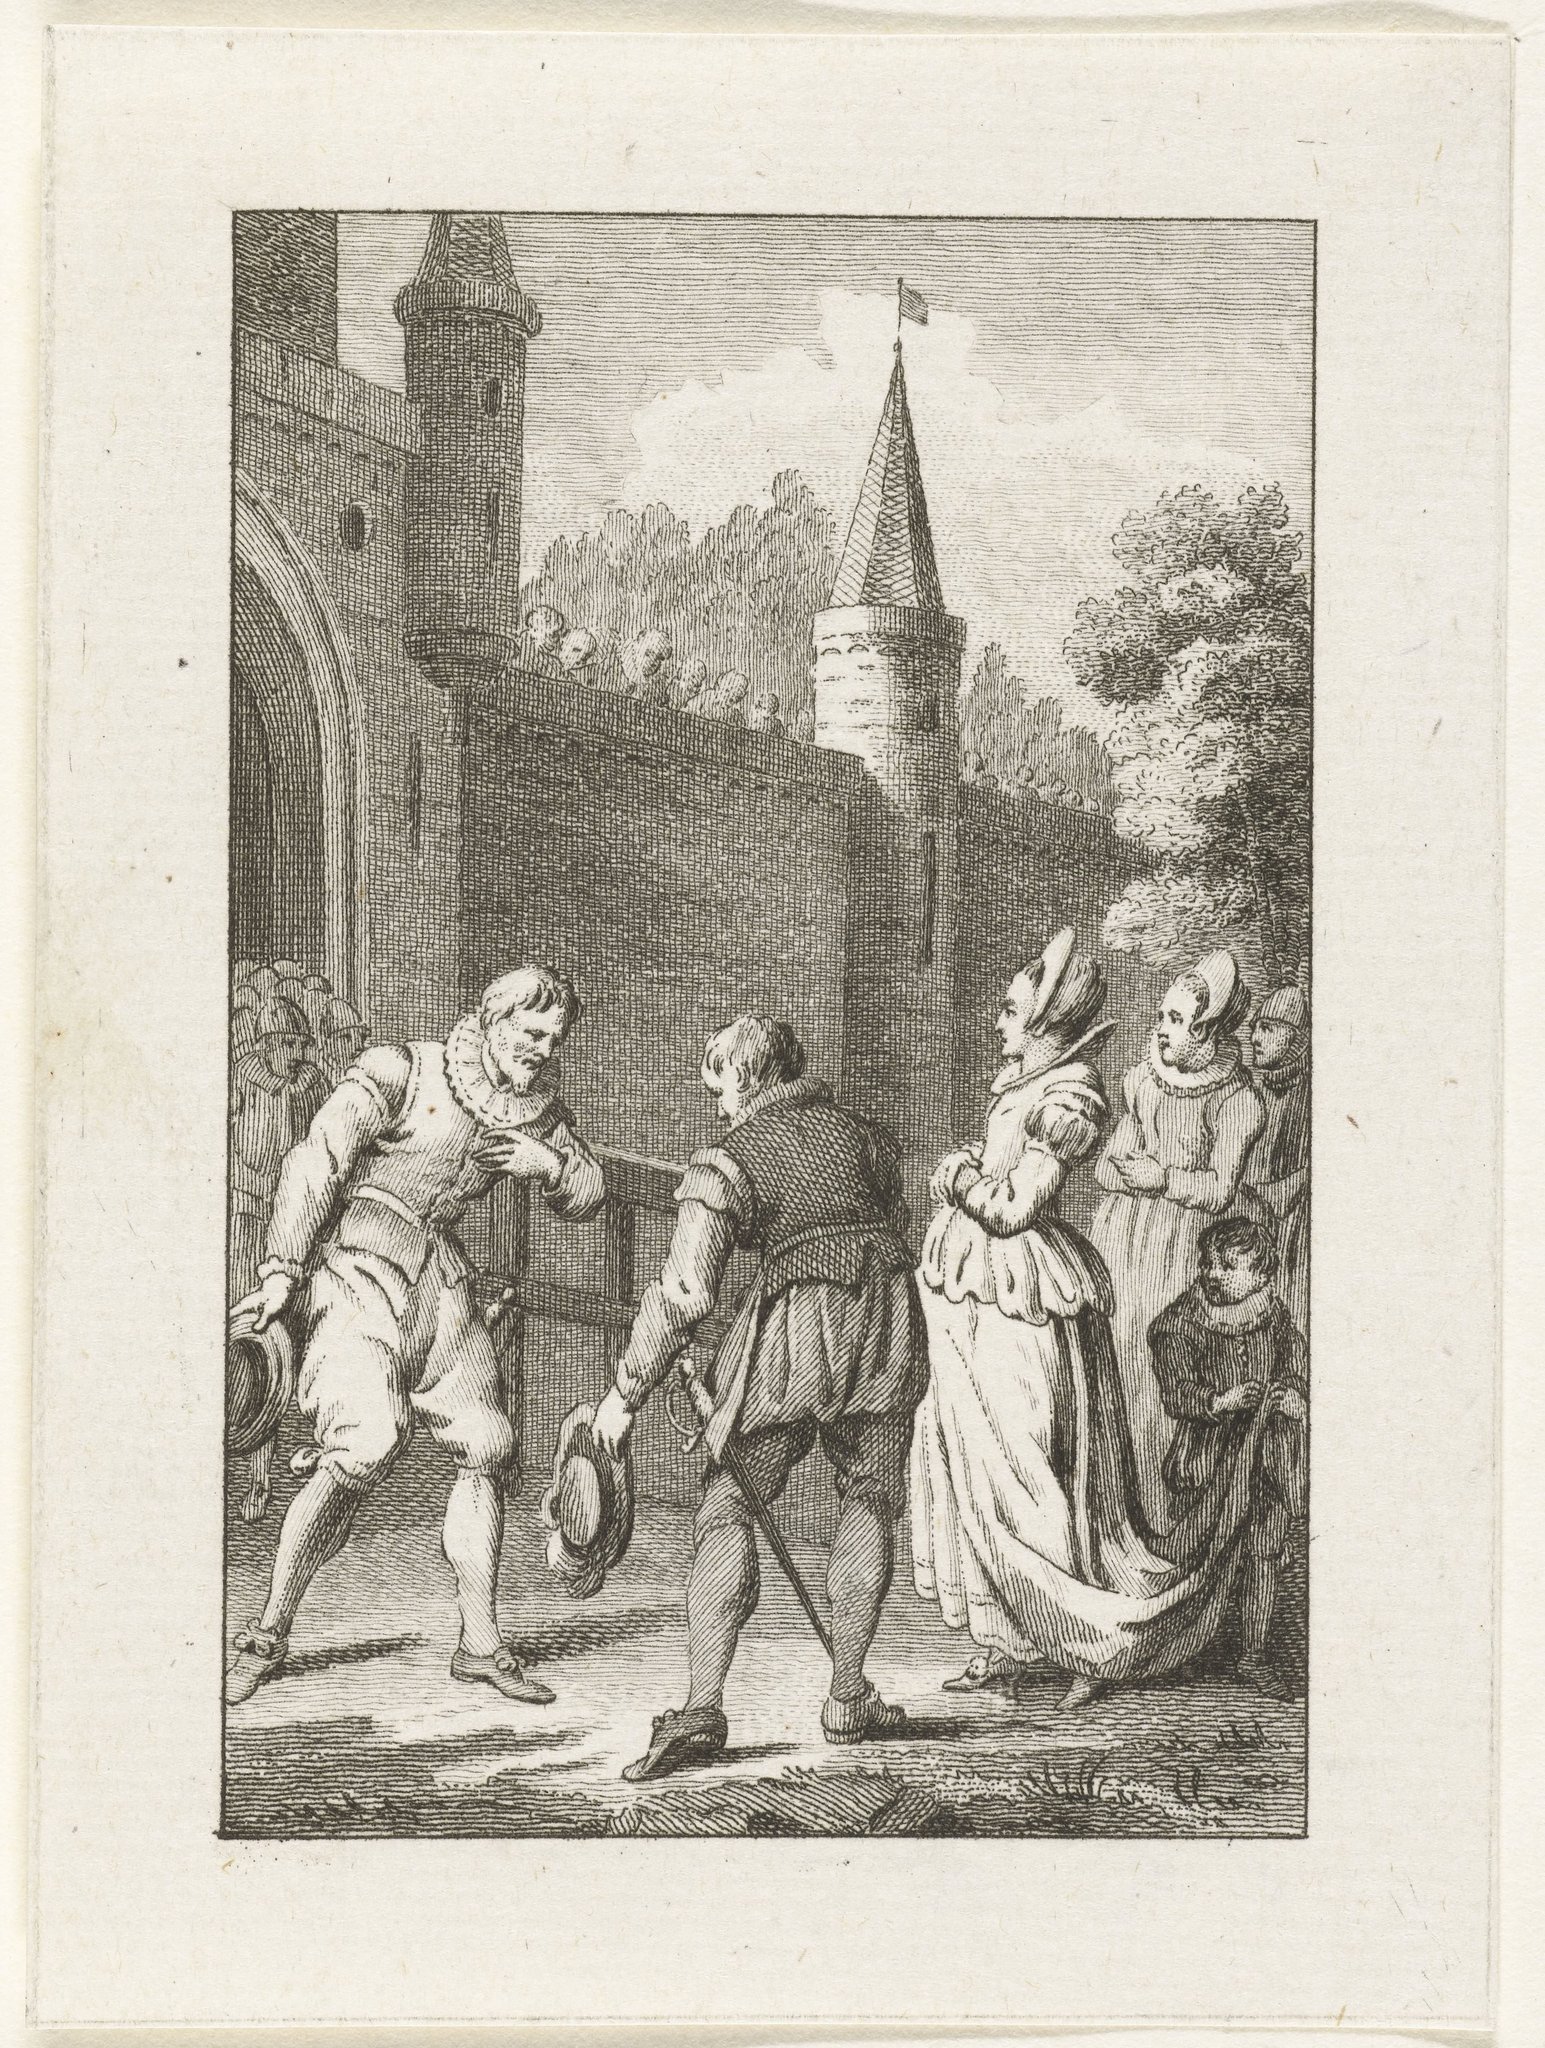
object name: print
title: Aankomst van Isabella te Haarlem, 1444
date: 1780-1795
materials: paper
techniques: etching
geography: netherlands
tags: bruges, philip iii the good, haarlem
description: Illustratie voor: J. Fokke, Geschiedenissen der Vereenigde Nederlanden voor de vaderlandsche jeugd, Johannes Allart, Amsterdam 1783-1795, 25 delen, dl. III, pl. I. Staat vóór de letter.